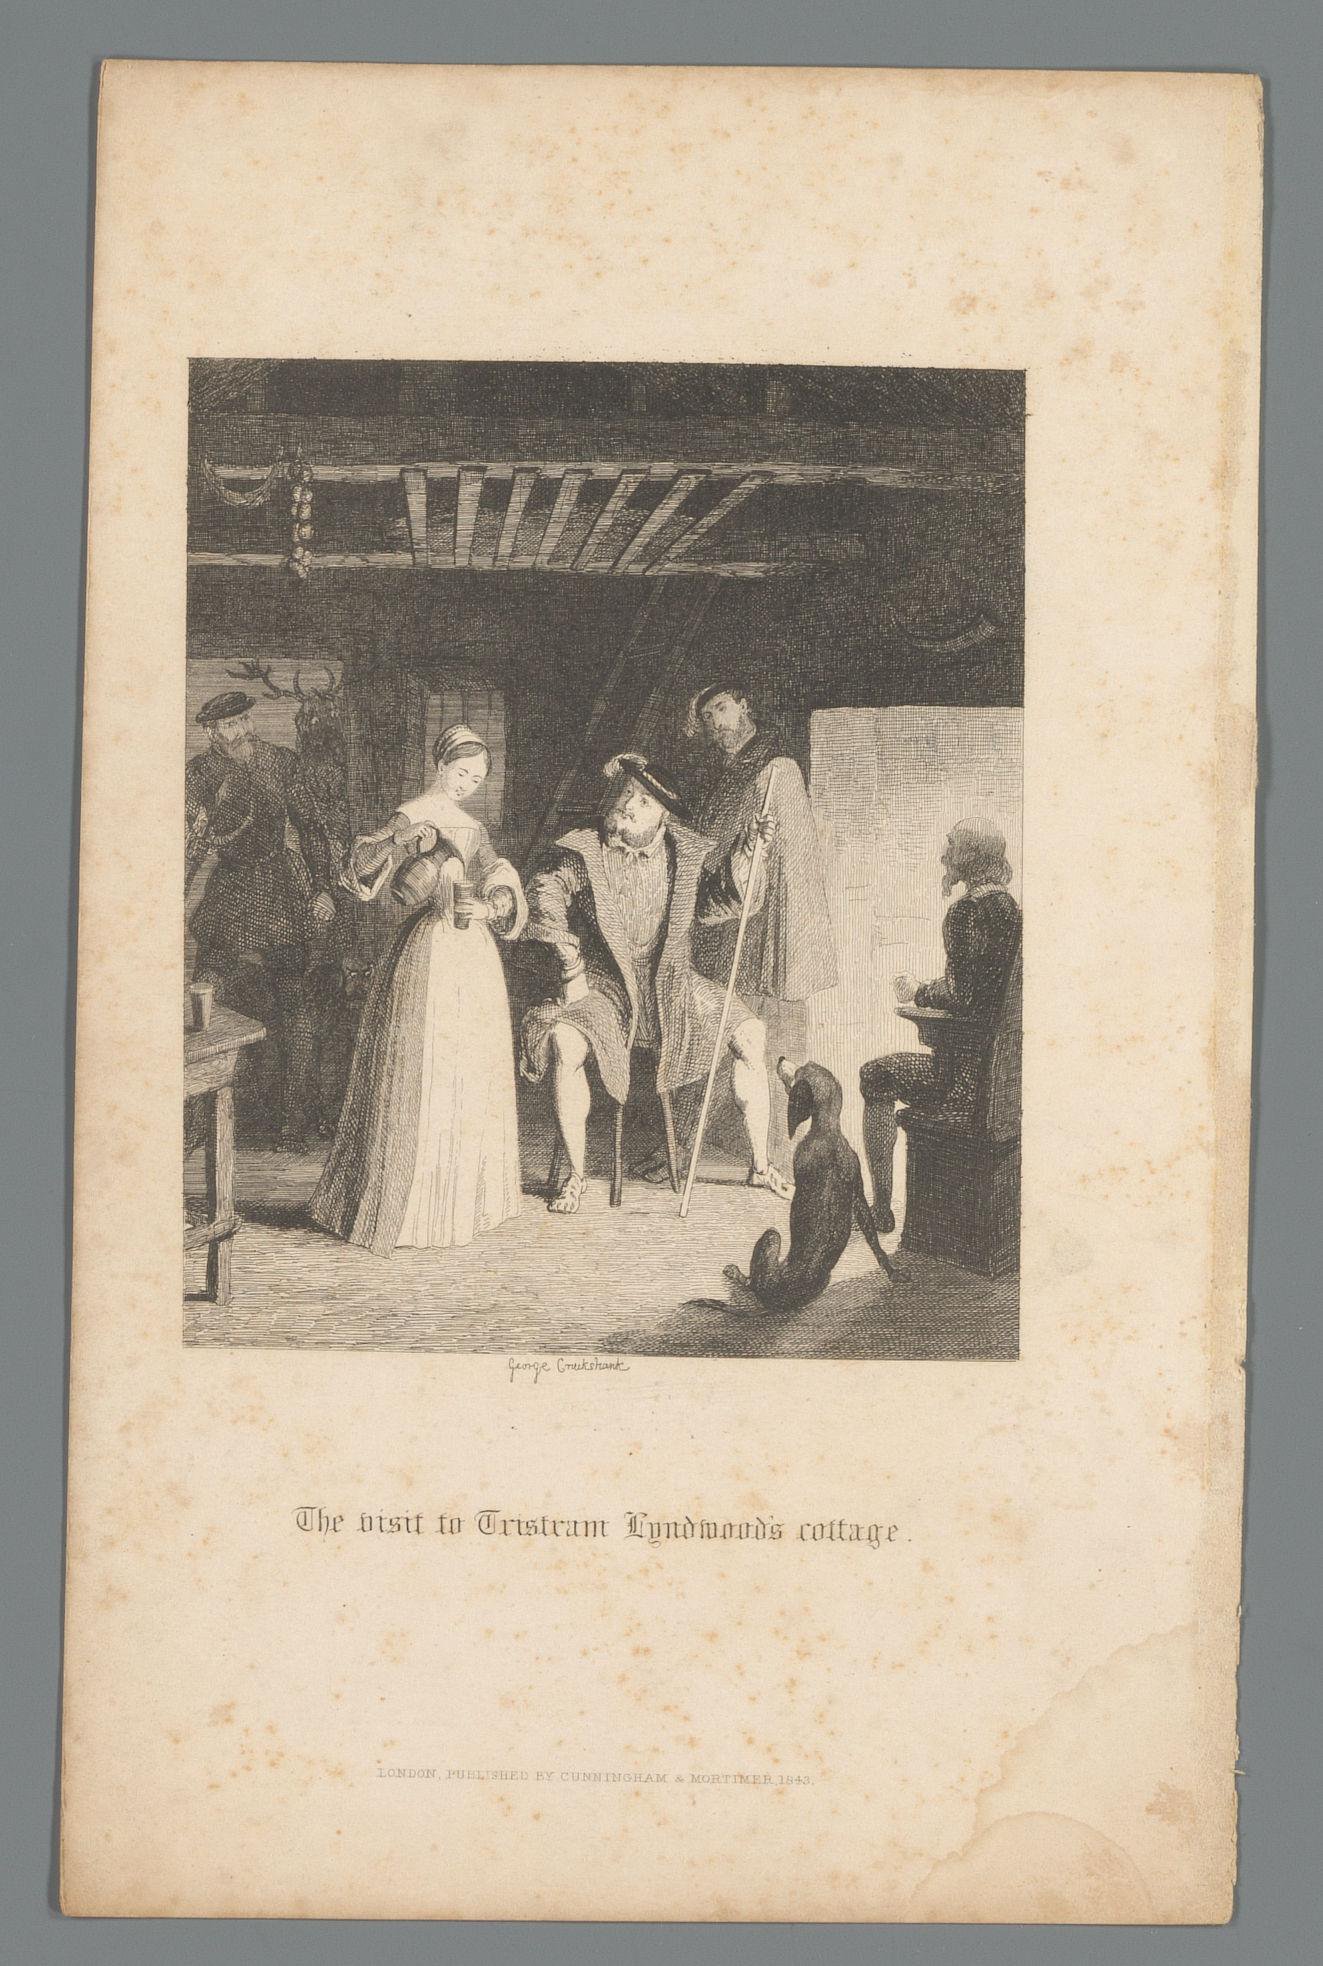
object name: cartoon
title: The visit to Tristram Lyndwood's cottage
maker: george cruikshank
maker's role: painter, print maker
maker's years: 1792-1878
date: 1843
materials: paper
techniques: etching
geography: london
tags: political caricatures and satires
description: Koning Hendrik VIII in de woning van Tristram Lyndwood. Illustratie uit een uitgave van "Windsor Castle", van William Ainsworth (1843).